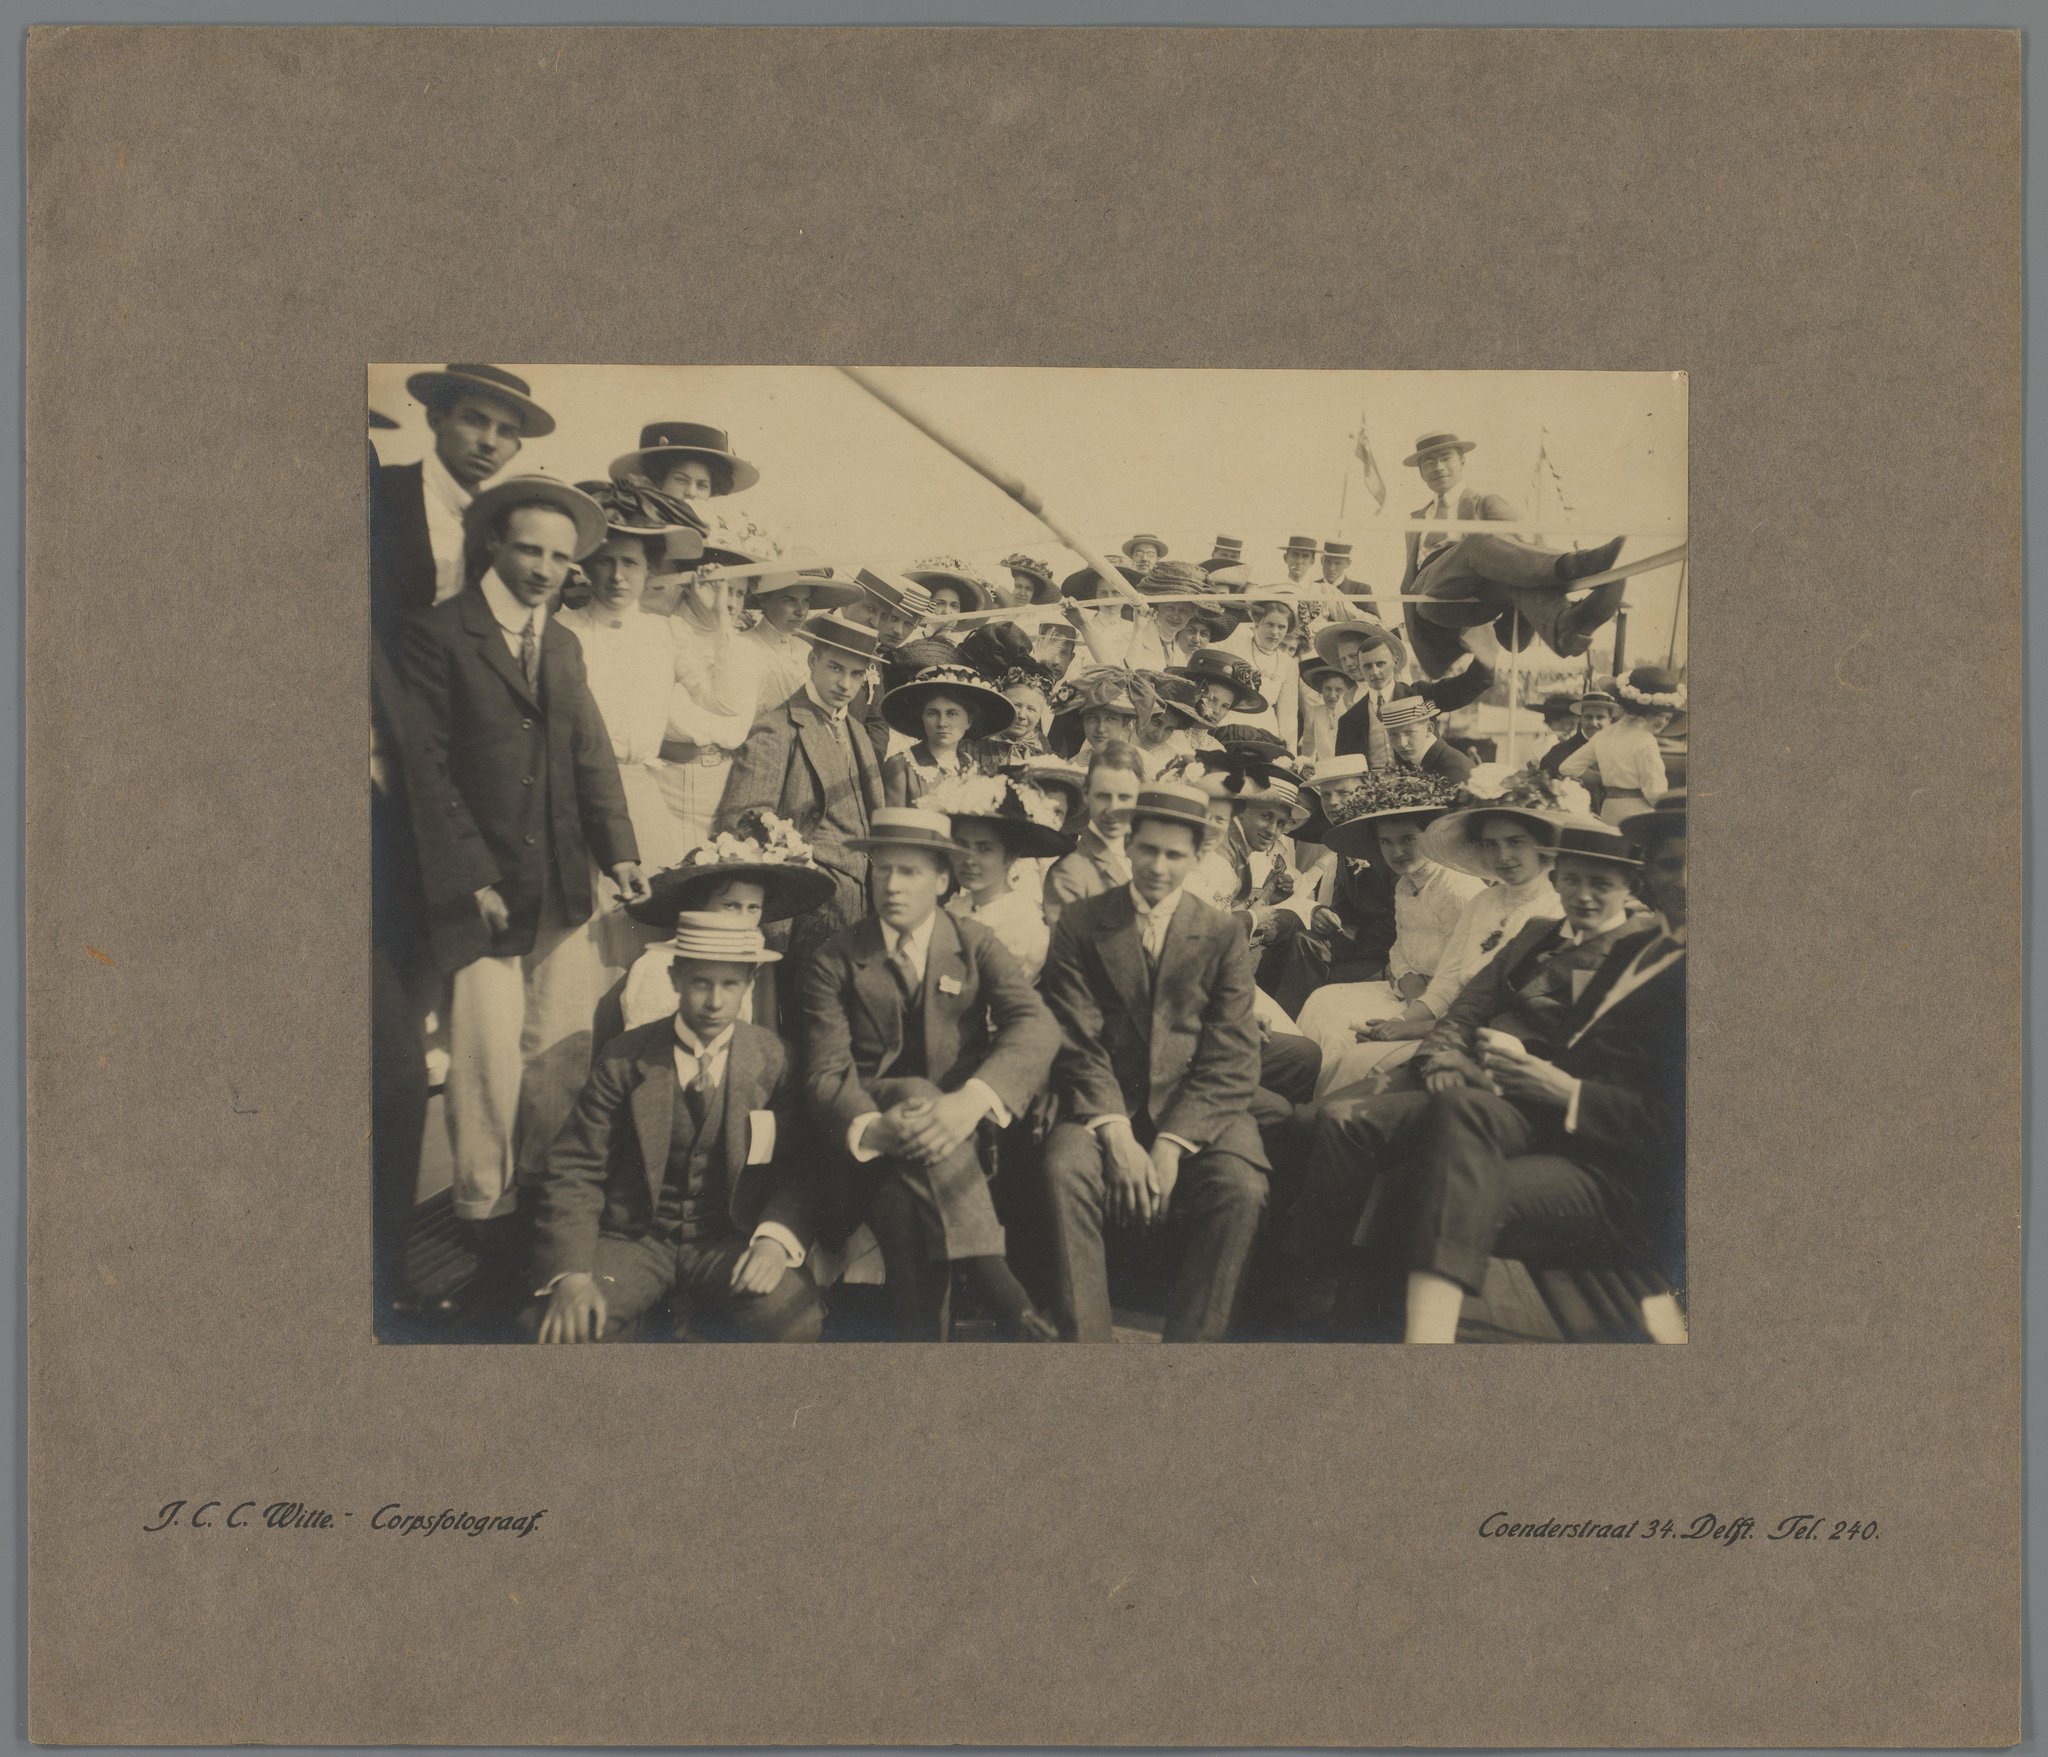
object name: photograph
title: Groepsportret met Johanna (Hans) de Jong en Frederik (Frits) Stokhuyzen bij een roeiwedstrijd van het Delftsch Studenten Corps in Zweth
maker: johannes christiaan coenraad witte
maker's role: fotograaf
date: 1911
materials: paper, cardboard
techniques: daylight paper print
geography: zweth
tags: leiden, johanna petronella lambertina stokhuyzen-de jong (hans), frederik stokhuyzen (frits), historical person (with name) - historical person (with name) portrayed in a group, in a group-portrait, students' organization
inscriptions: inscription: ‘J. C. C. Witte - Corpsfotograaf.’, inscription: ‘Roeiwedstrijd Zweth/ Hemelvaartsdag 1911.’, address: ‘Coenderstraat 34. Delft. Tel. 240.’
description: Midden-links Frederik (Frits) Stokhuyzen en Johanna (Hans) de Jong.